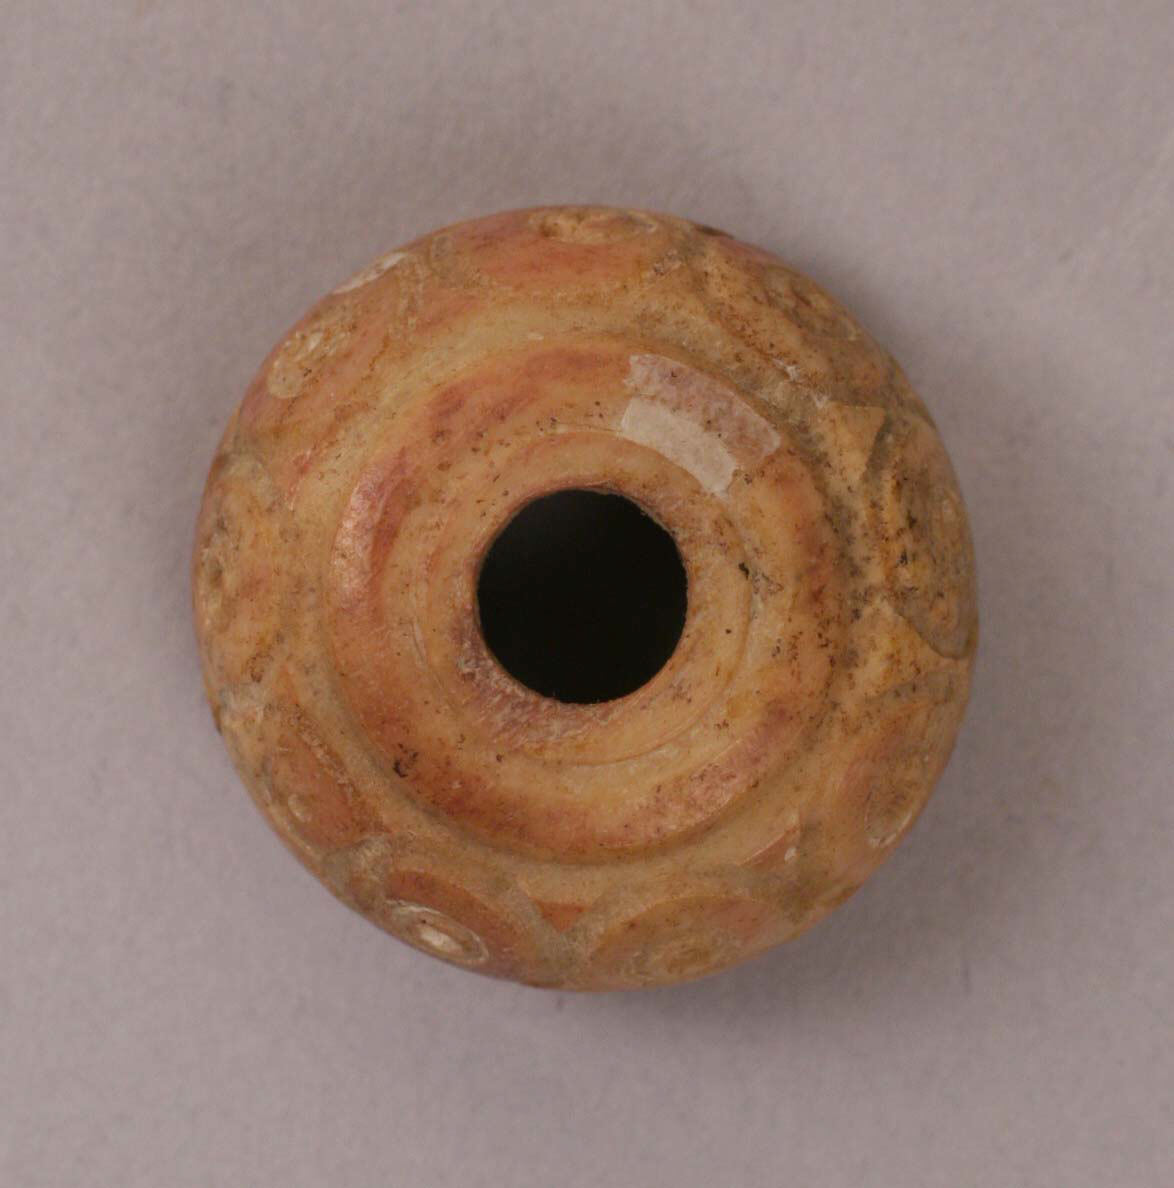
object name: button or bead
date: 801-1000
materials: bone, paint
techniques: incising, inlay, tinting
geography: iran